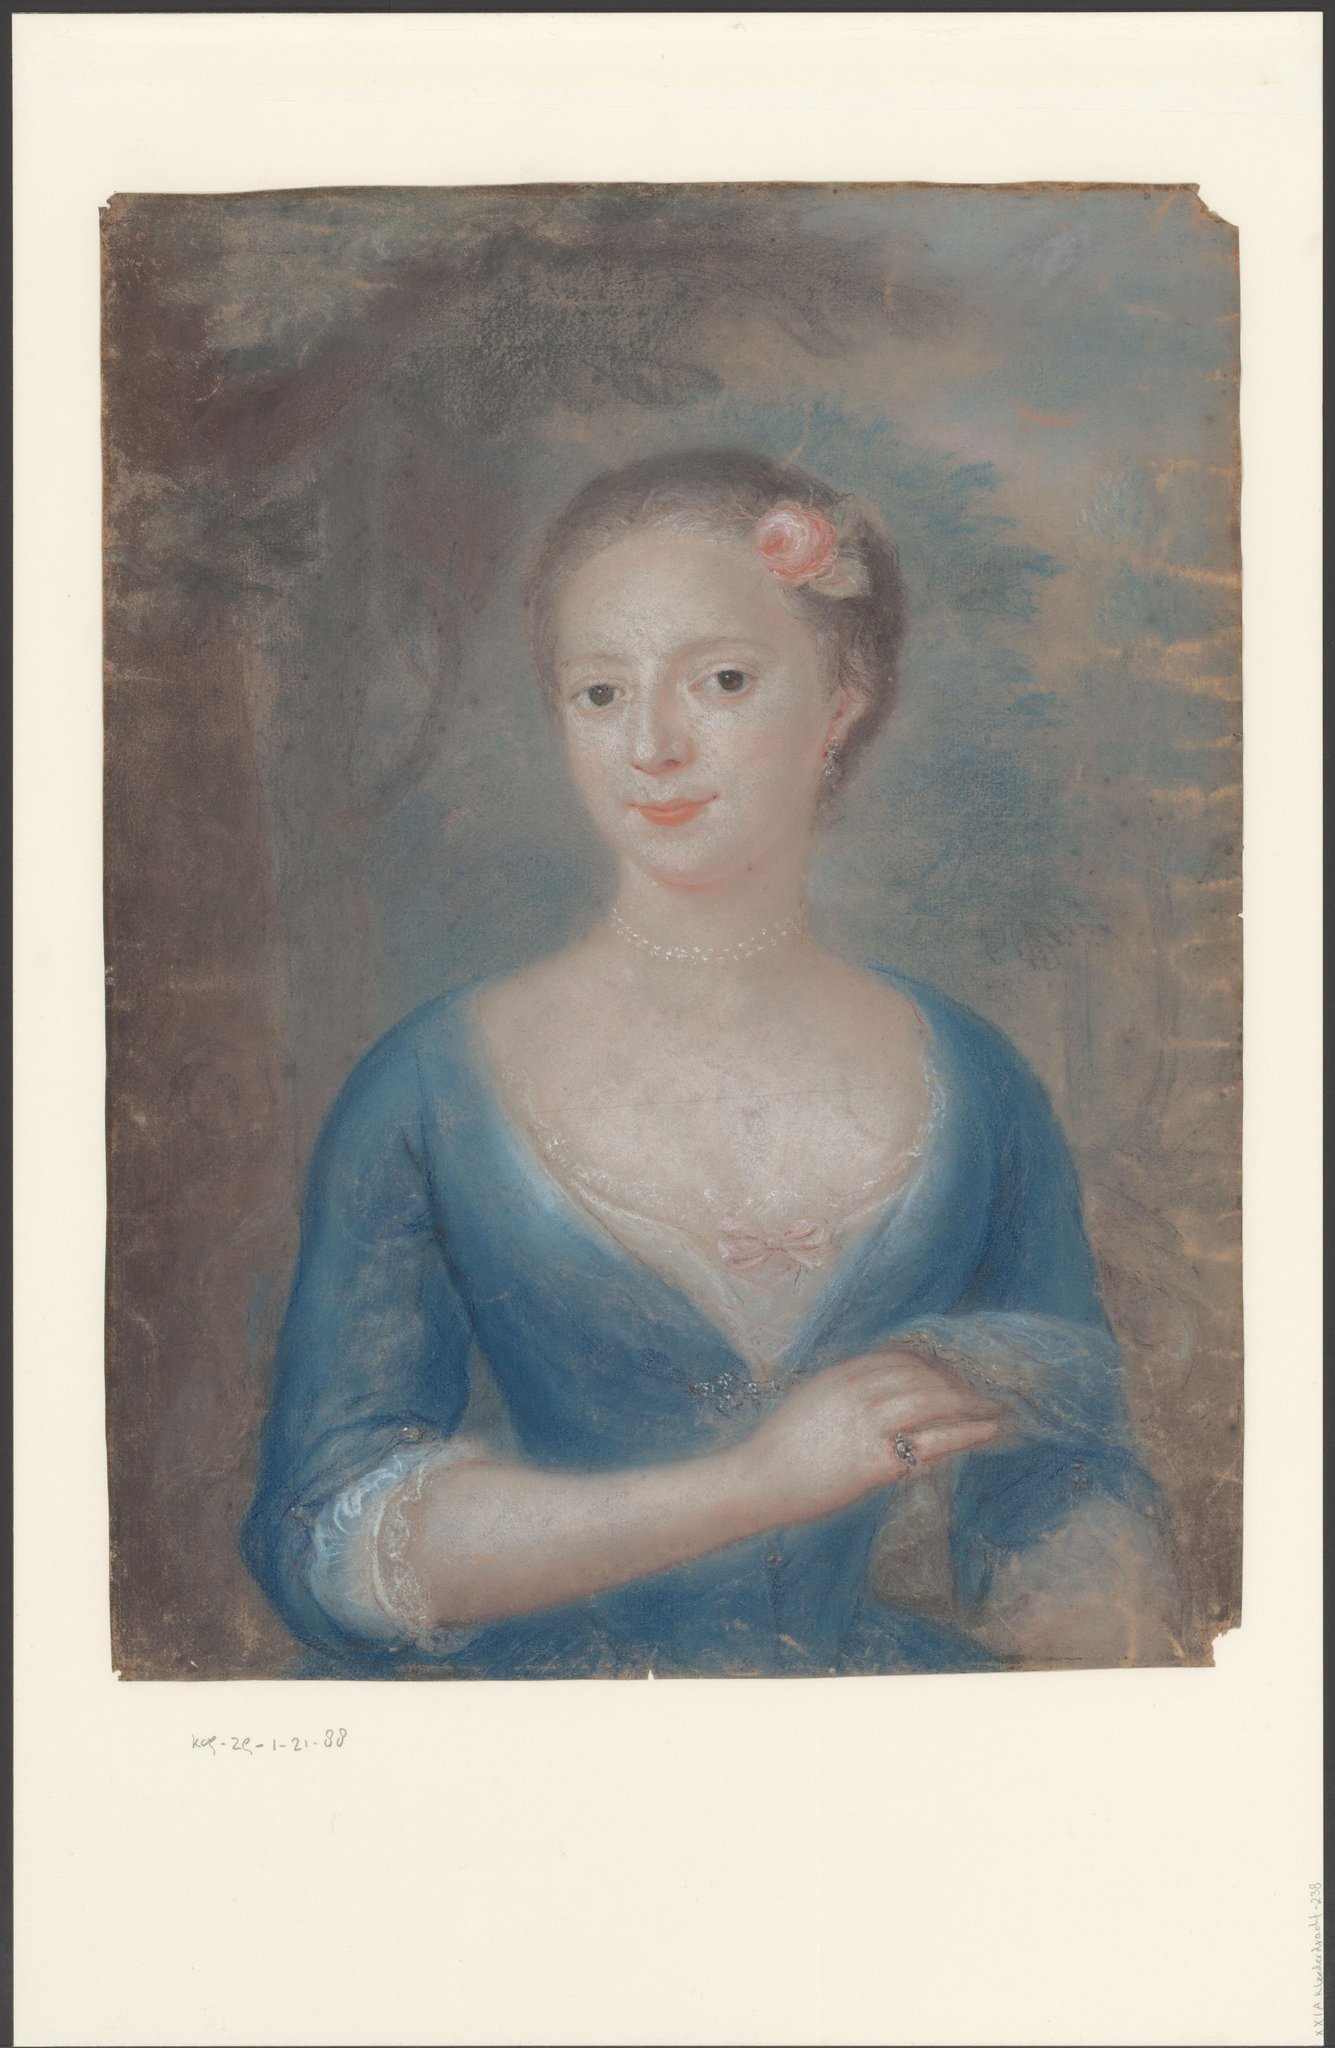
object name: drawing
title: Portret van een onbekende vrouw met roos in het haar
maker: Anonymous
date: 1700-1799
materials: paper, pastel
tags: historical persons - bb - woman, ring, flowers: rose, dress, gown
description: Onderwerpsrubrieken binnen de Atlas Zeden en Gewoonten: Zeden en Gewoonten in Engeren Zin, De Kleeding, Kleederdrachten (tijdvakken), De 18de eeuw (de pruikentijd). Mannen en vrouwen.